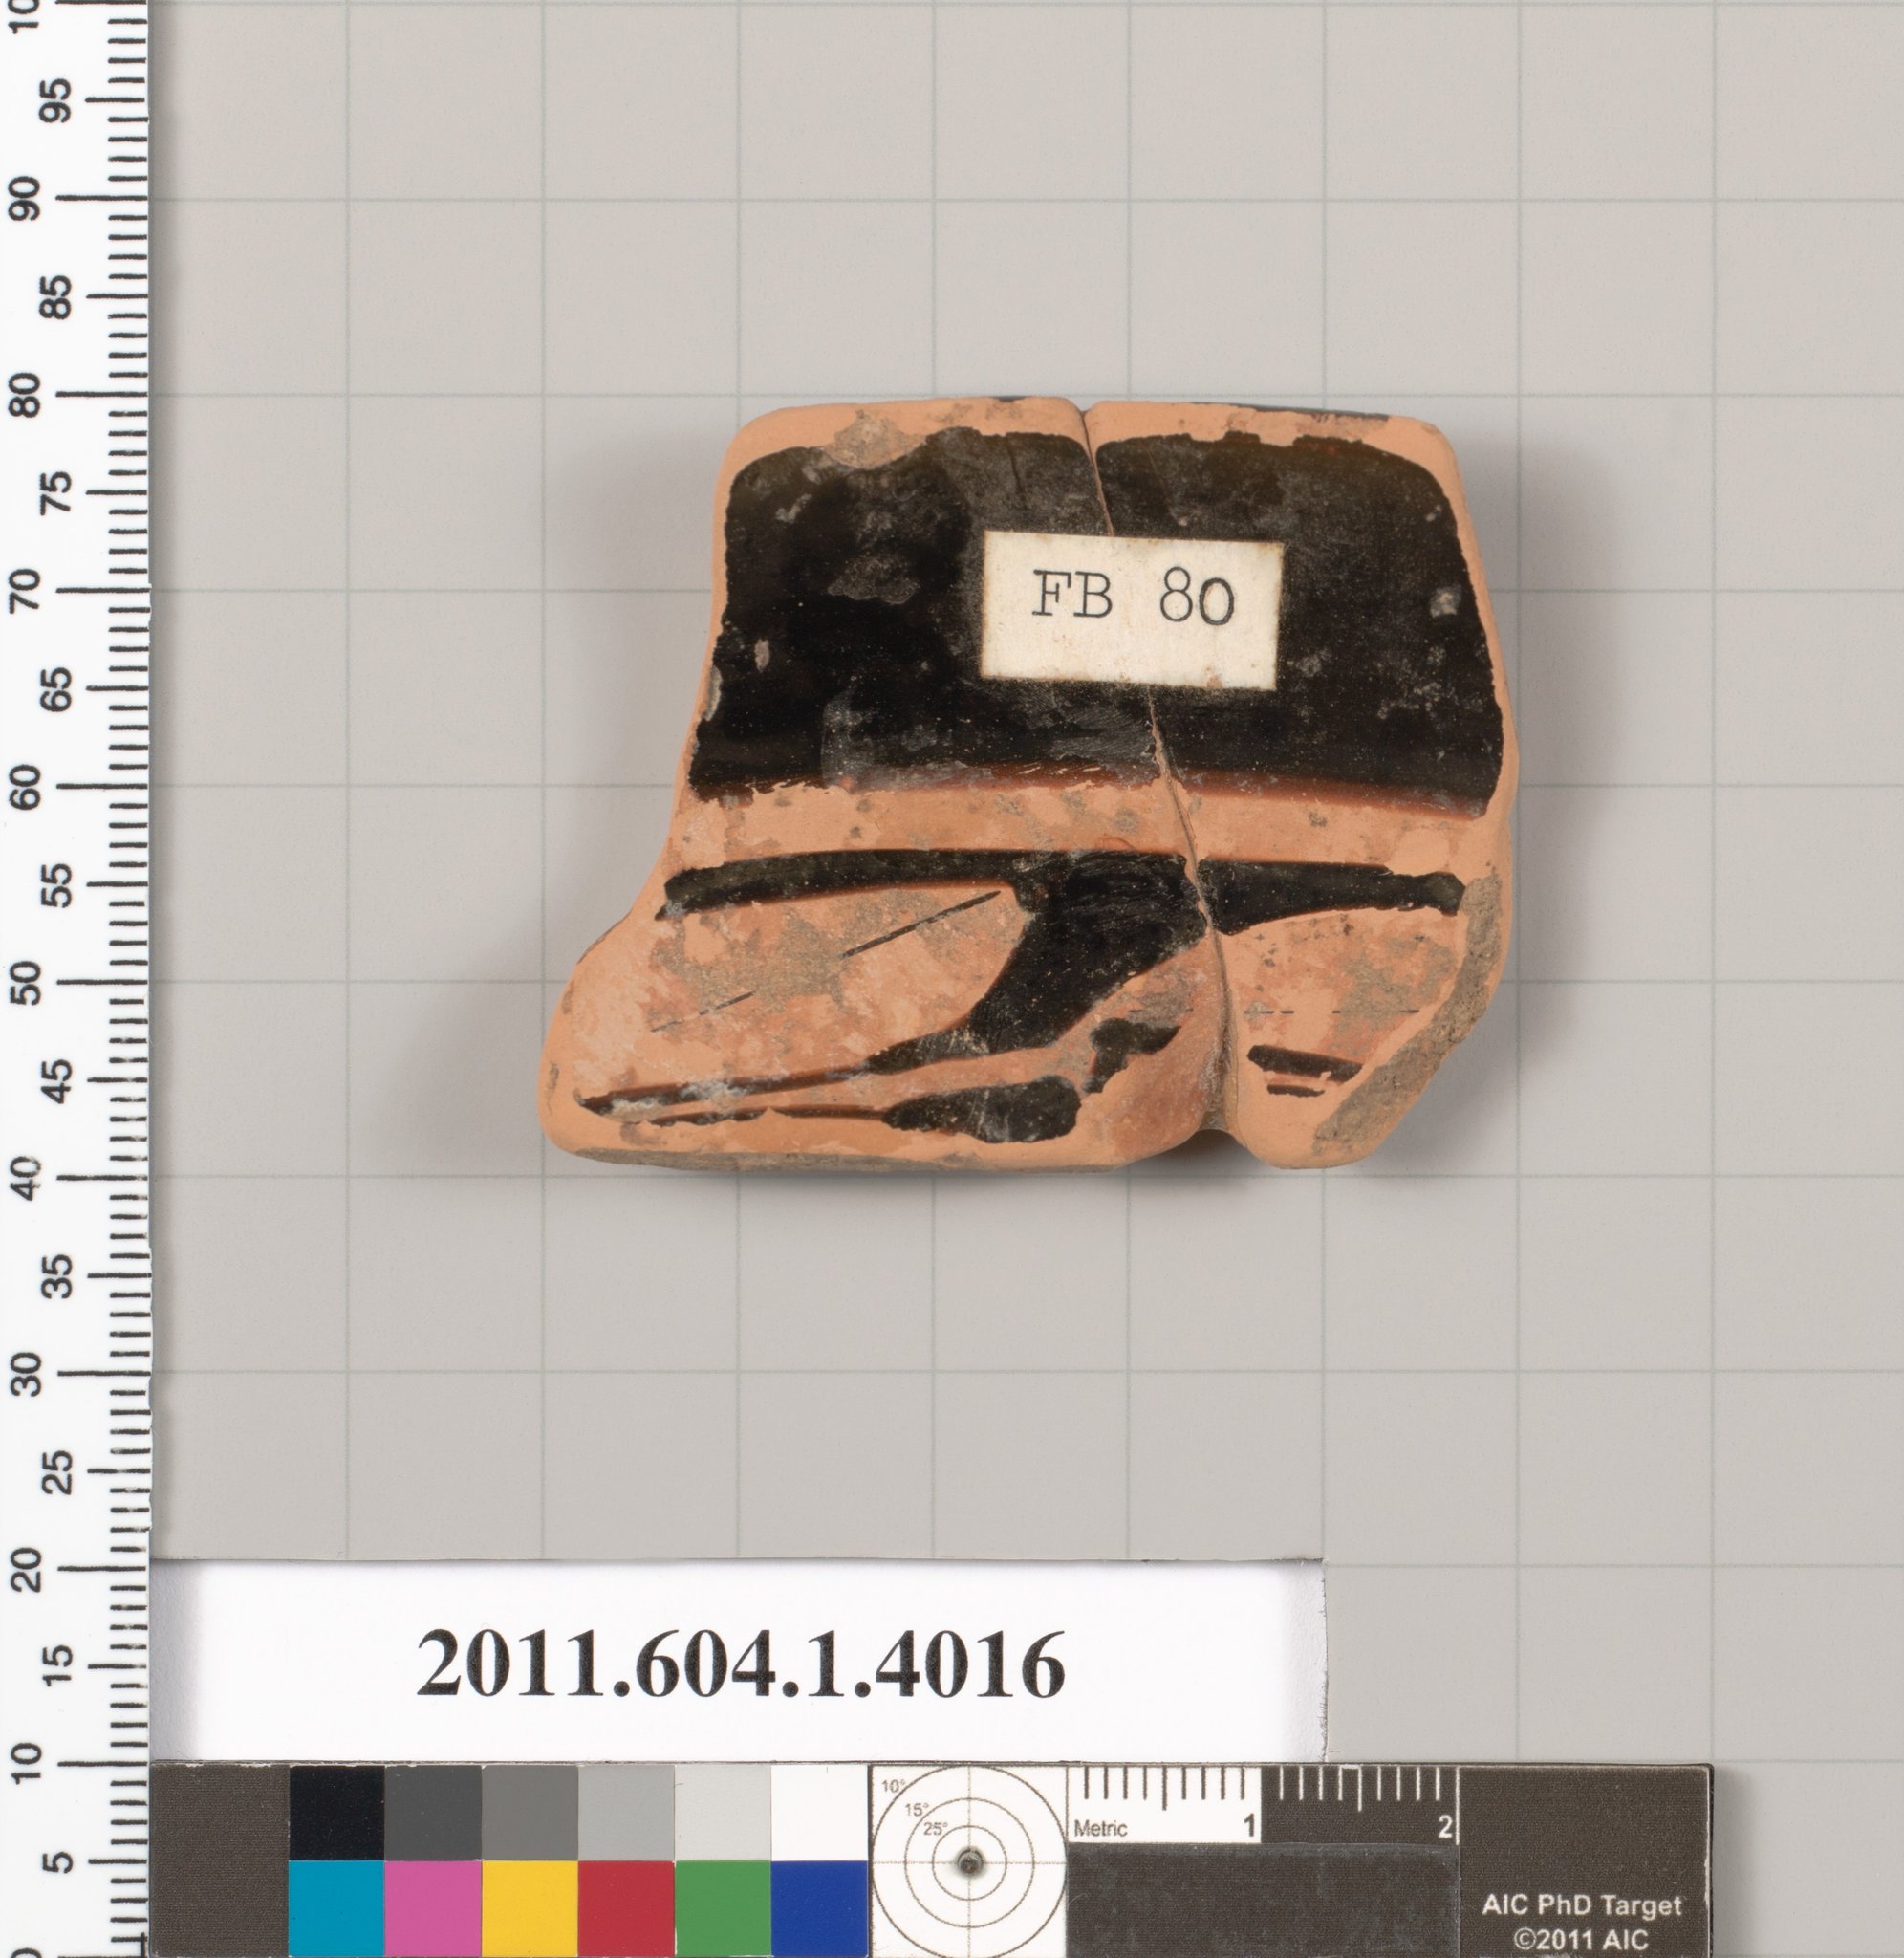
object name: kylix fragment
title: Terracotta fragment of a kylix (drinking cup)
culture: greek, attic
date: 460-440 BCE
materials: terracotta